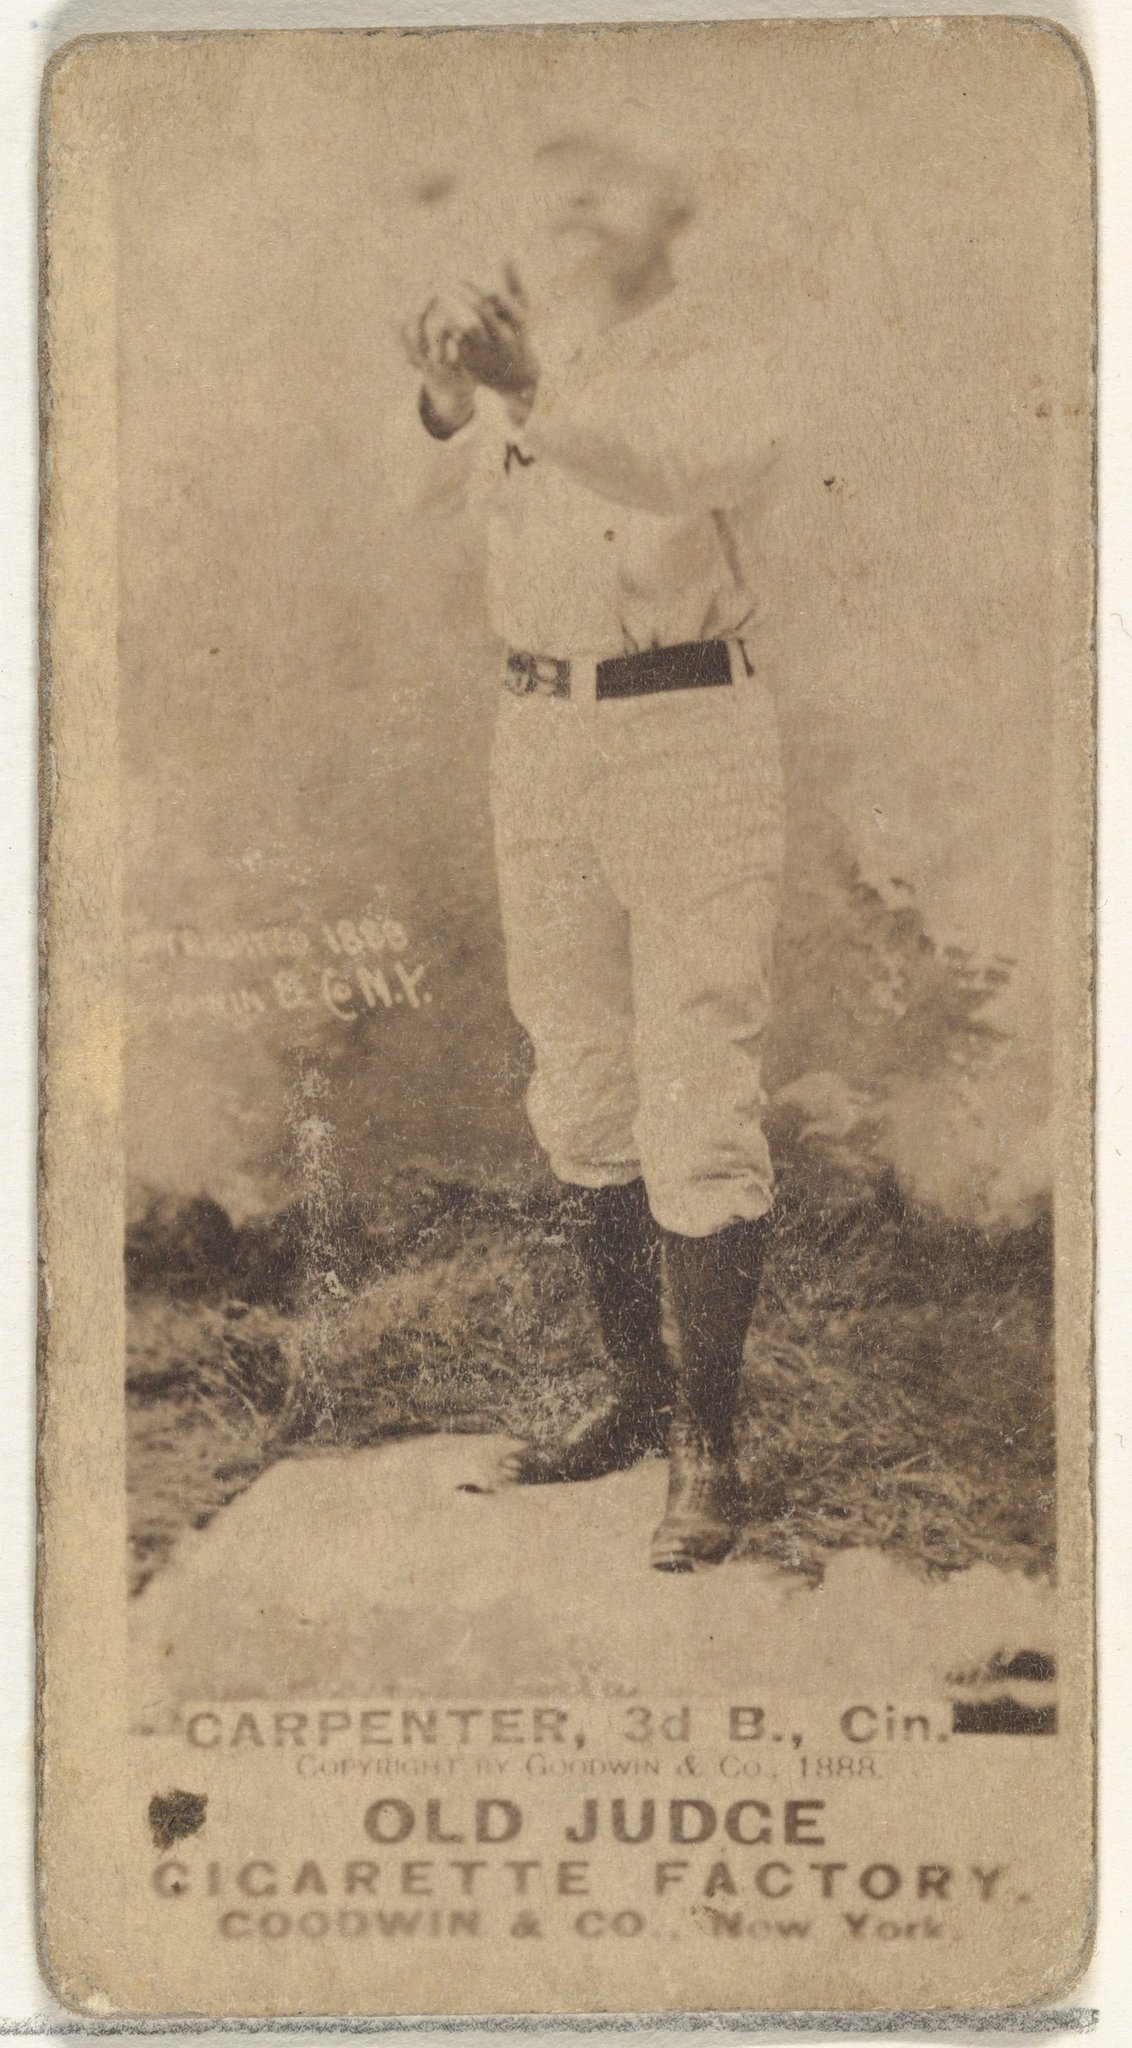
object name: baseball card, photograph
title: Warren William "Hick" Carpenter, 3rd Base, Cincinnati, from the Old Judge series (N172) for Old Judge Cigarettes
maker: goodwin & company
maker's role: publisher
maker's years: 1850-1950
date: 1888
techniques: albumen silver print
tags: men,portraits,baseball,athletes